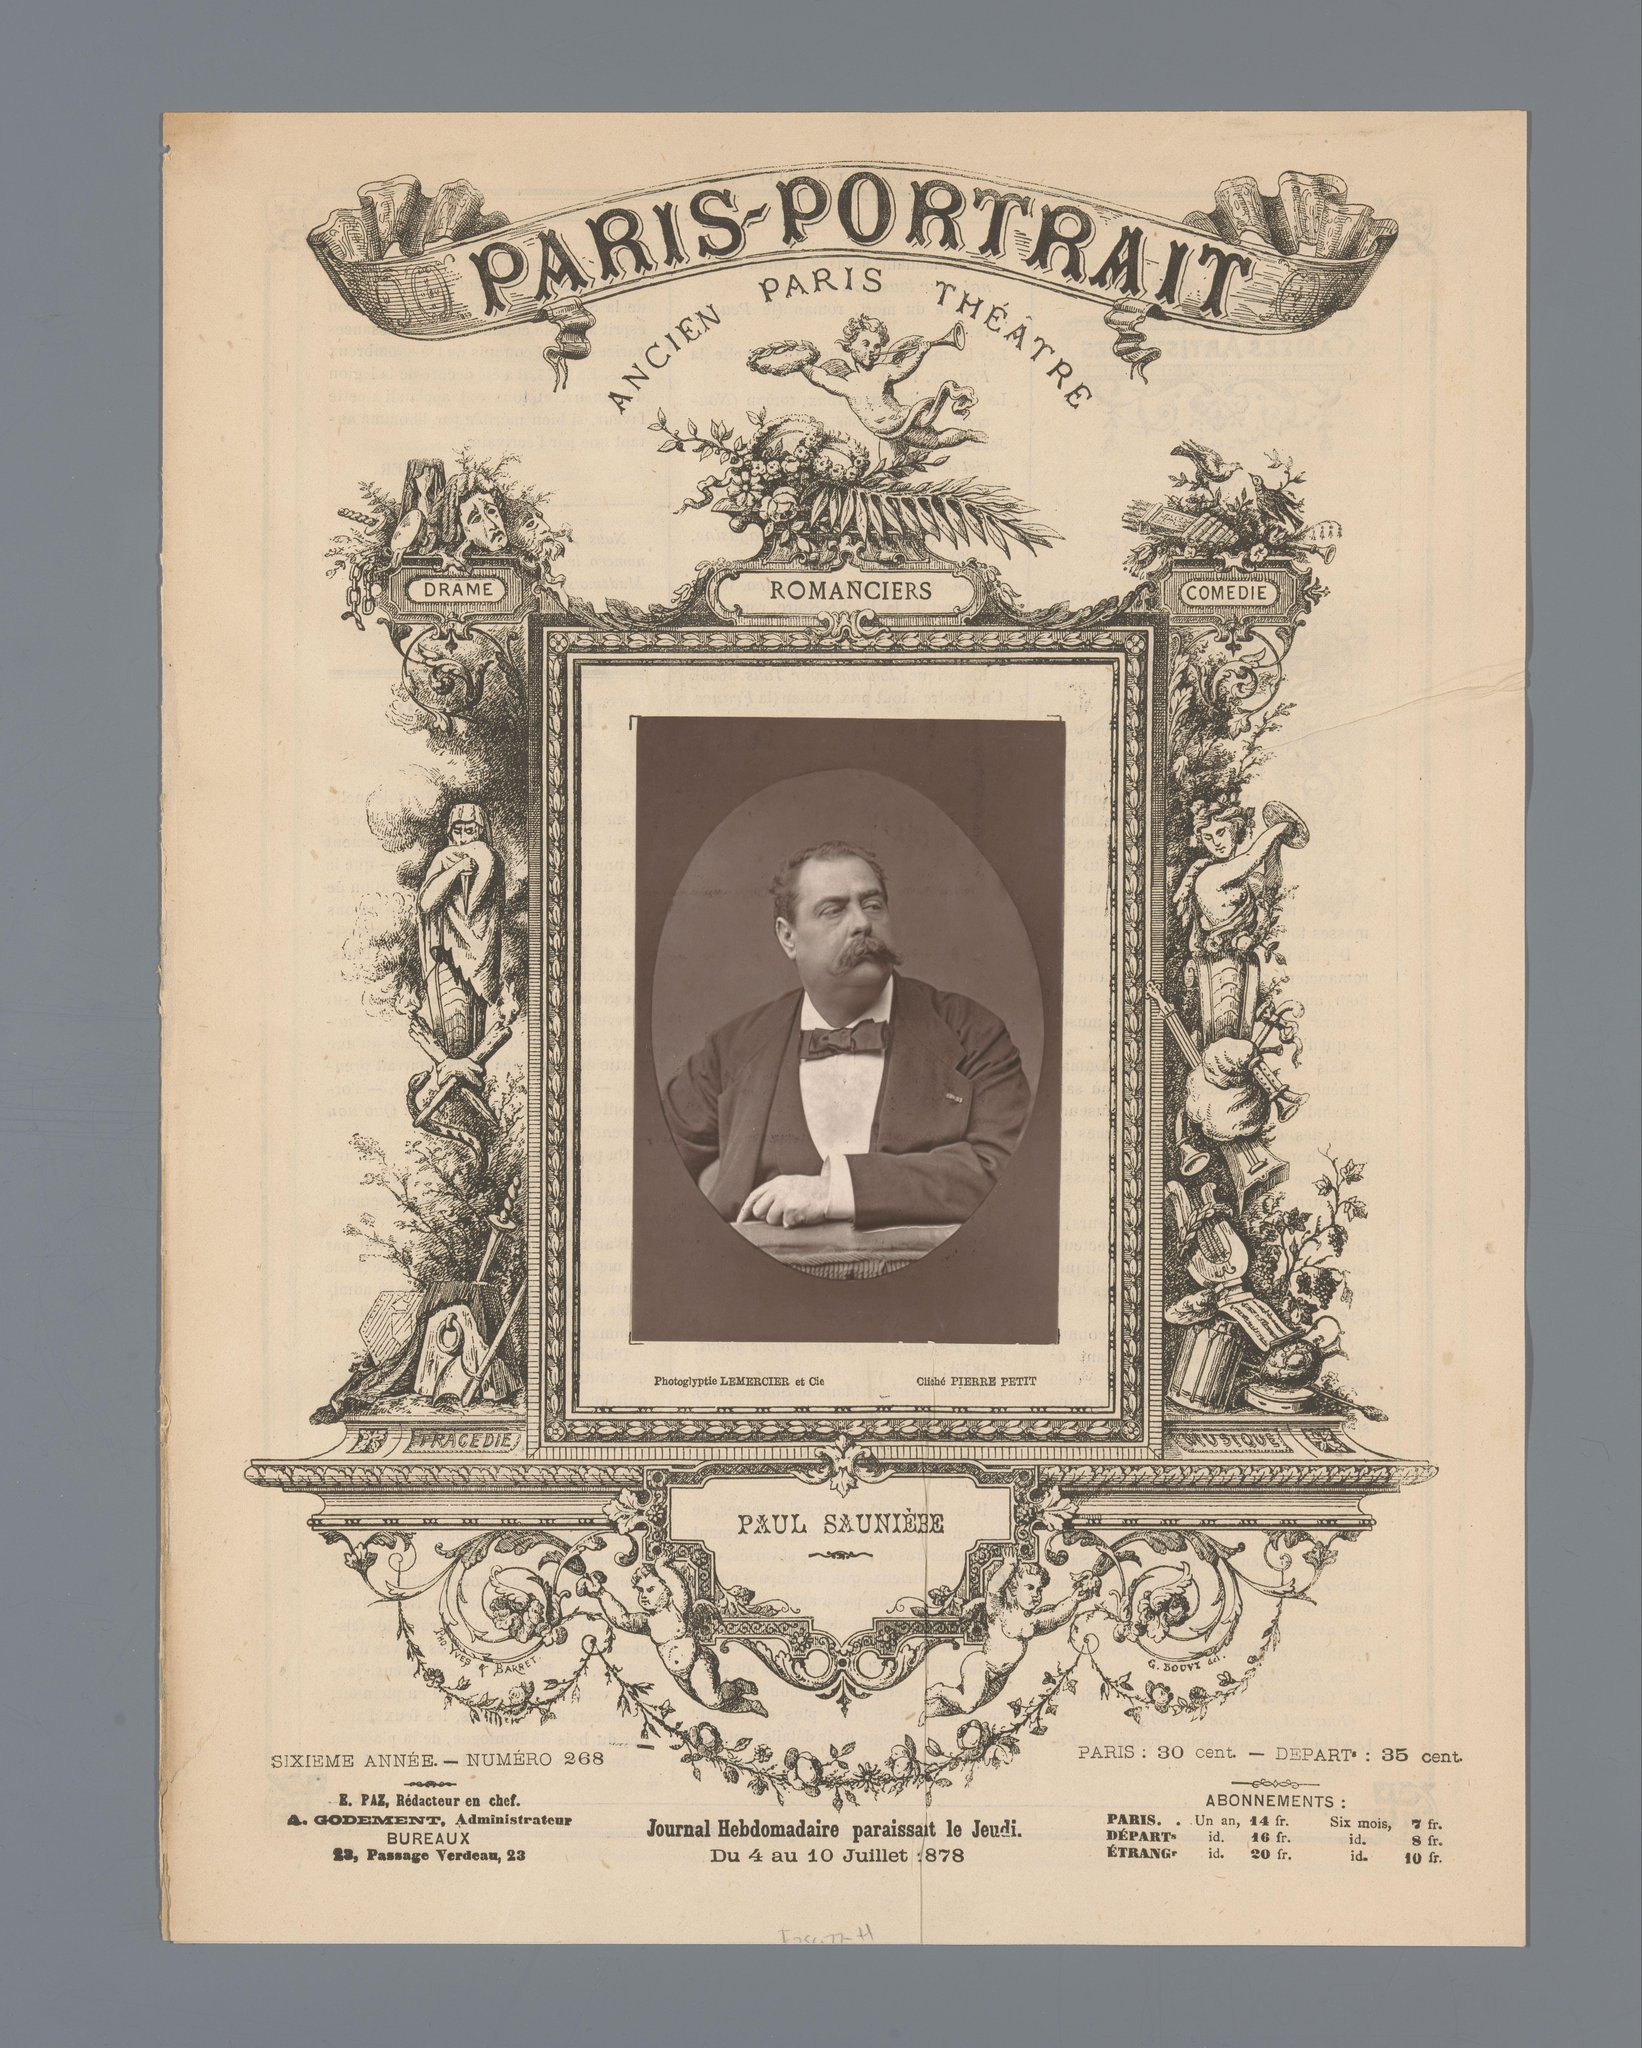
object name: photomechanical print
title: Paul Saunièbe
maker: pierre petit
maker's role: fotograaf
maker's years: 1832-1909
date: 1873-1880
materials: paper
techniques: woodburytype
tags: paris, historical persons